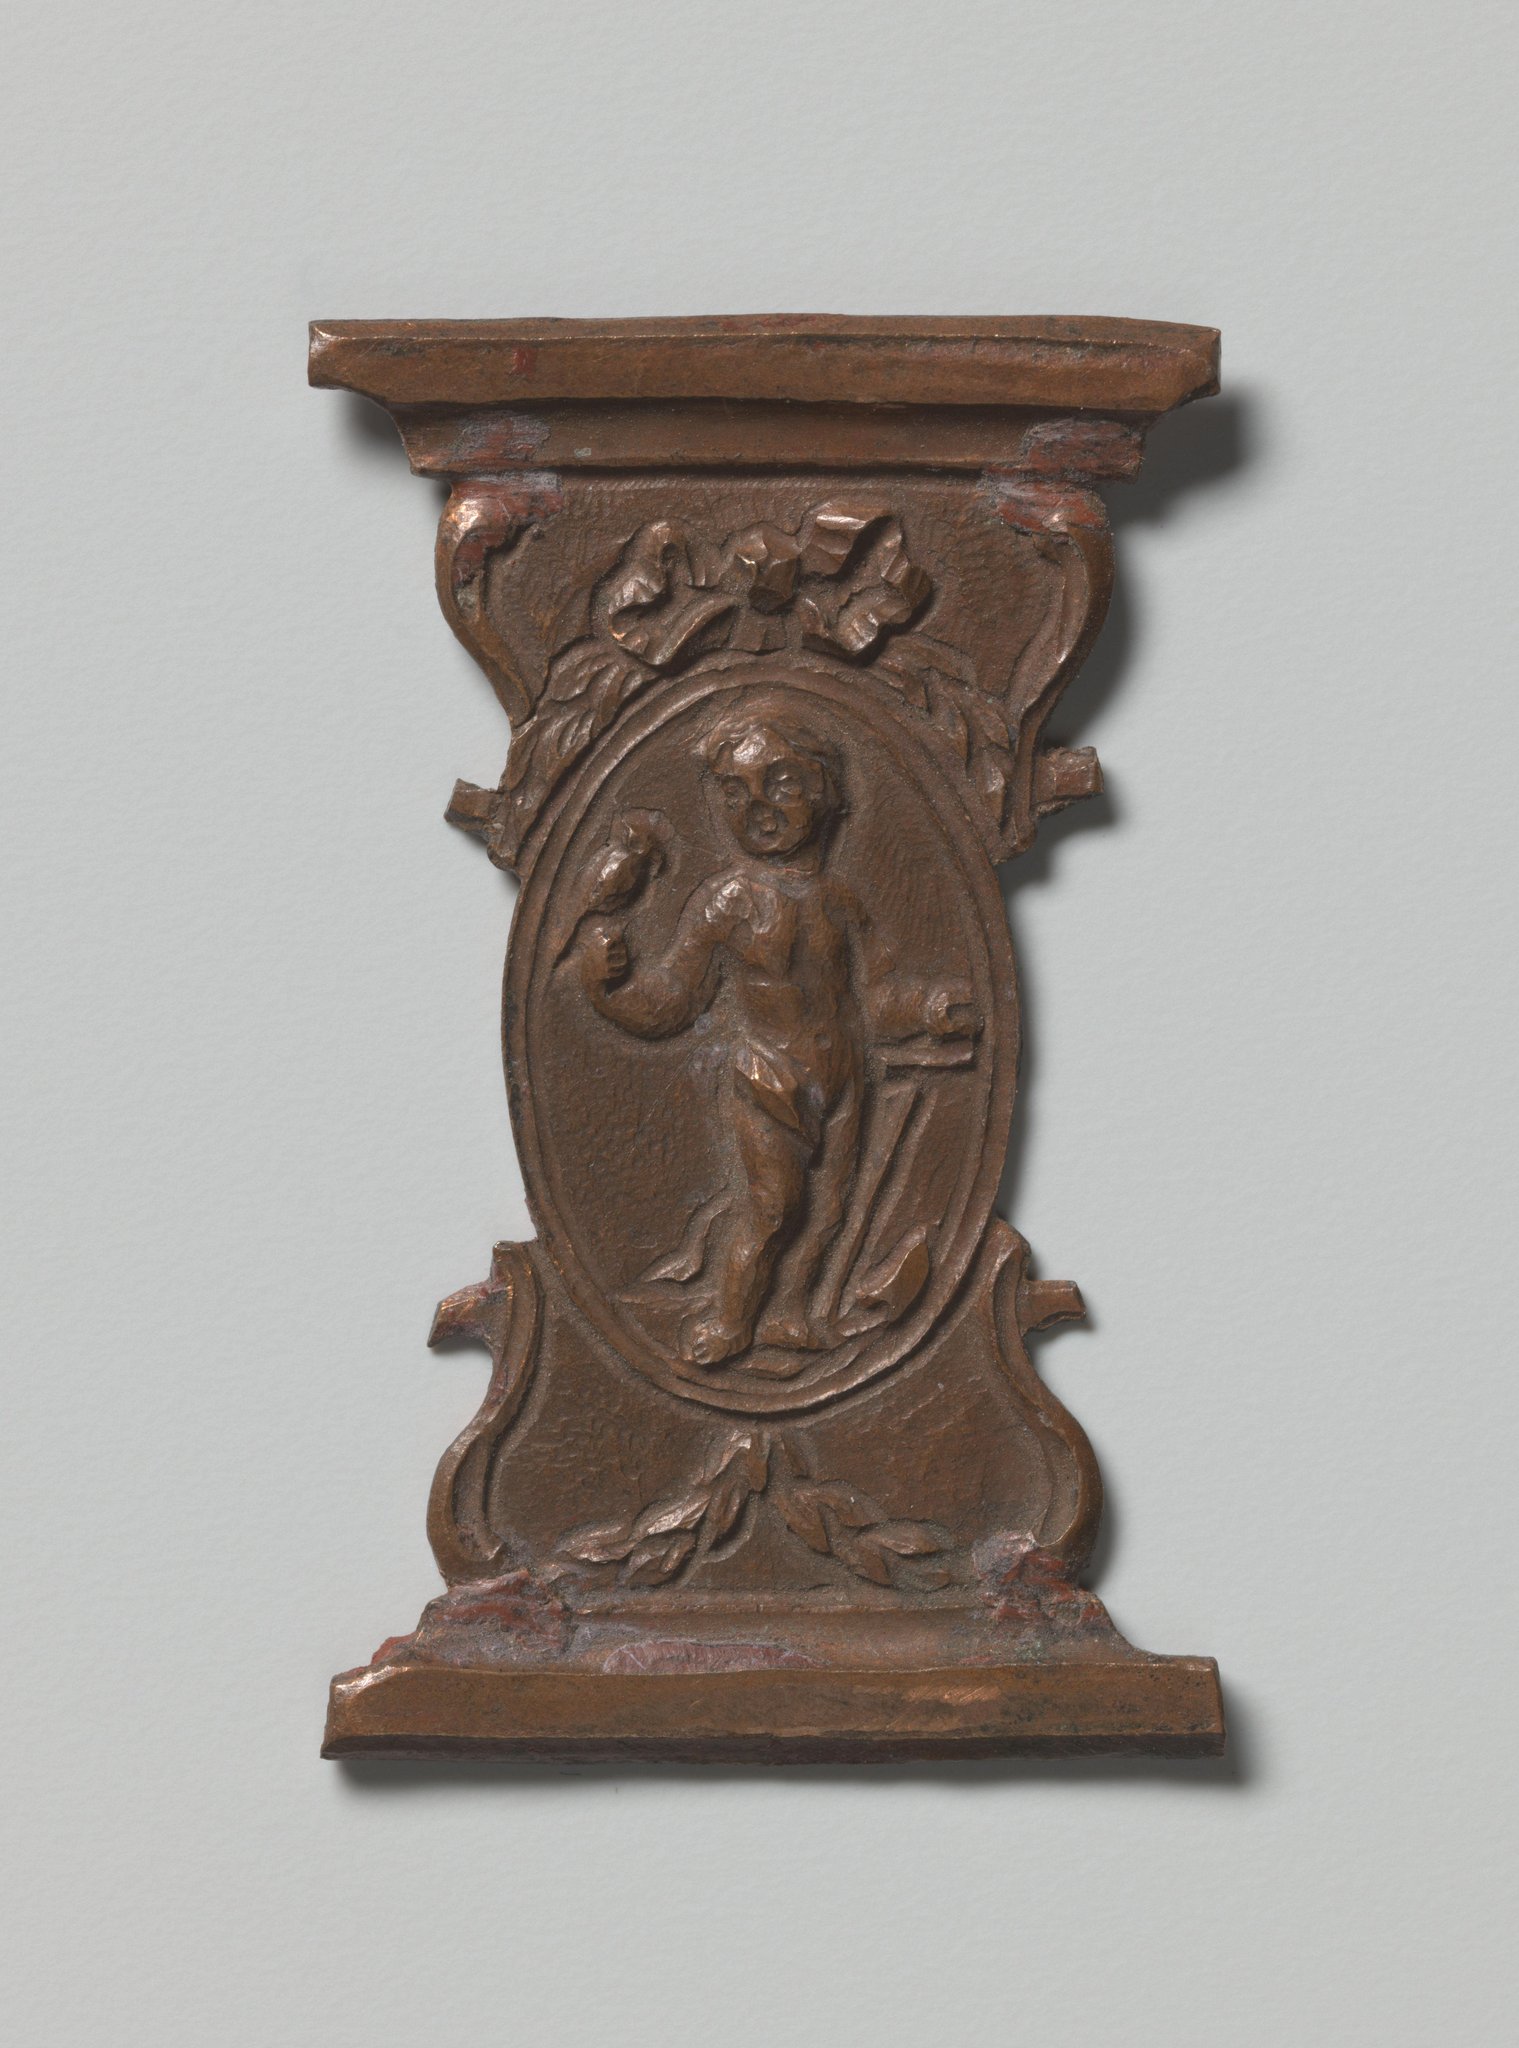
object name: boekslot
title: Model voor een beugel van een boekslot met een kind met anker en vogel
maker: Anonymous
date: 1750-1775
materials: copper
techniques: repoussé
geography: amsterdam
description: Het uit plaat gedreven model voor een gietvorm is versierd met een medaillon aan een strik en slinger. In het medaillon is een kind met anker en vogel weergegeven.